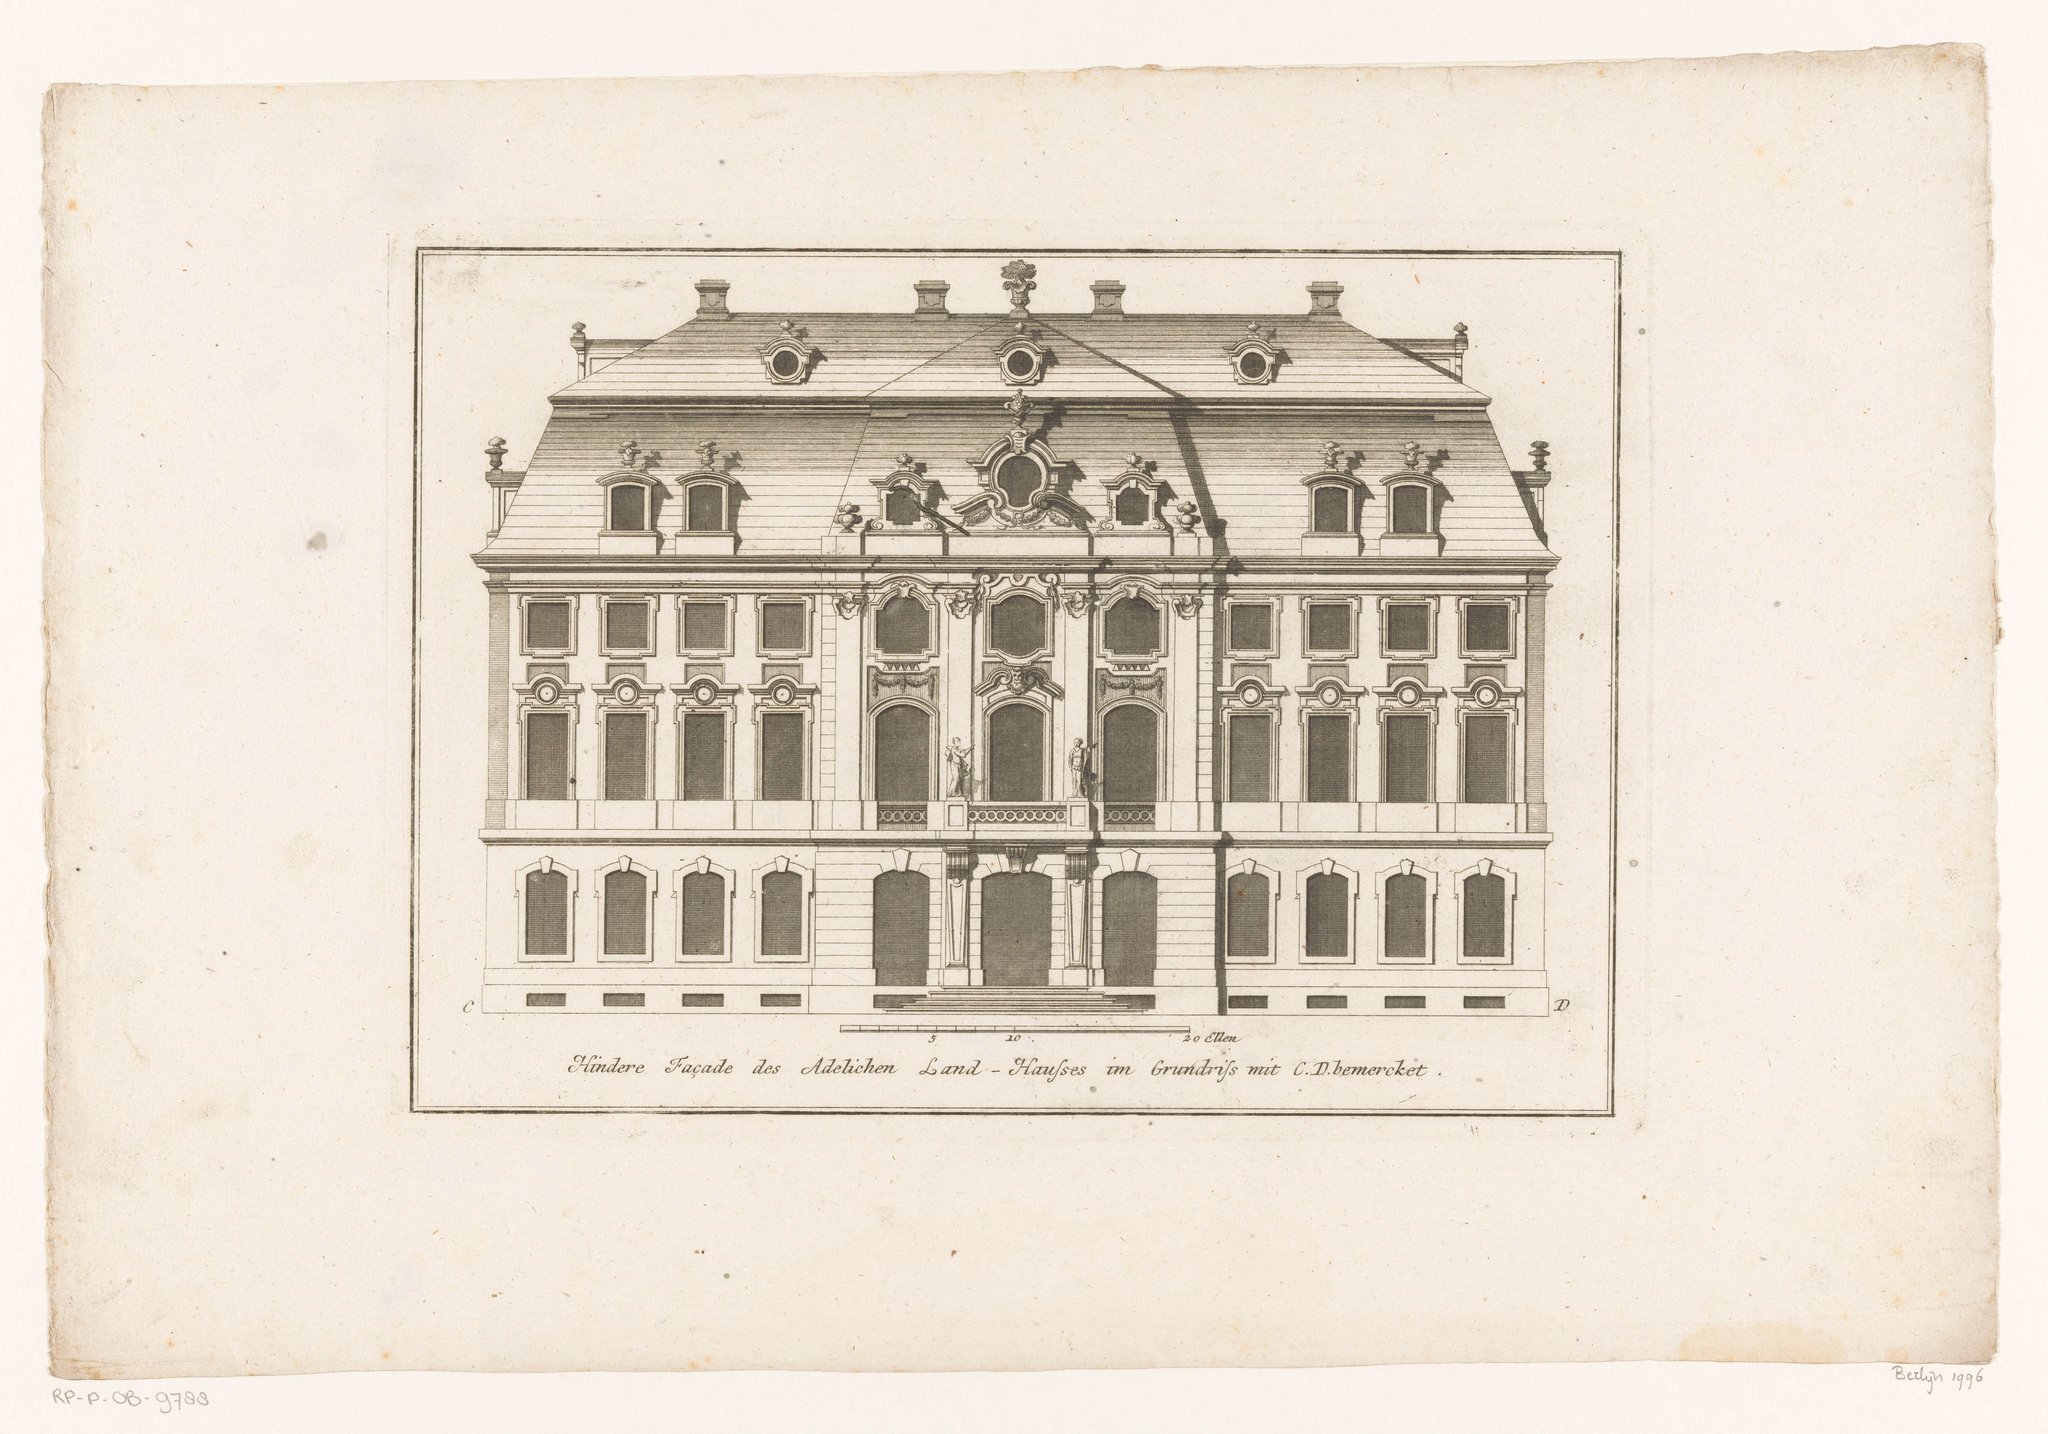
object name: print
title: Joh. Rudolph Fäsches (...) Anderen Versuchs Fünffter Theil Sr. Architecton: Wercke bestehend in allerhand Grund-Haupt-Rissen u: Profilen unterschiedener gebäude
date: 1729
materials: paper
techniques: engraving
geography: nuremberg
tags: rear façade, country-house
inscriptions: collector's mark: Lugt 2228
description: Mogelijk prent 19, 20, 21 of 22 uit een serie van 25.